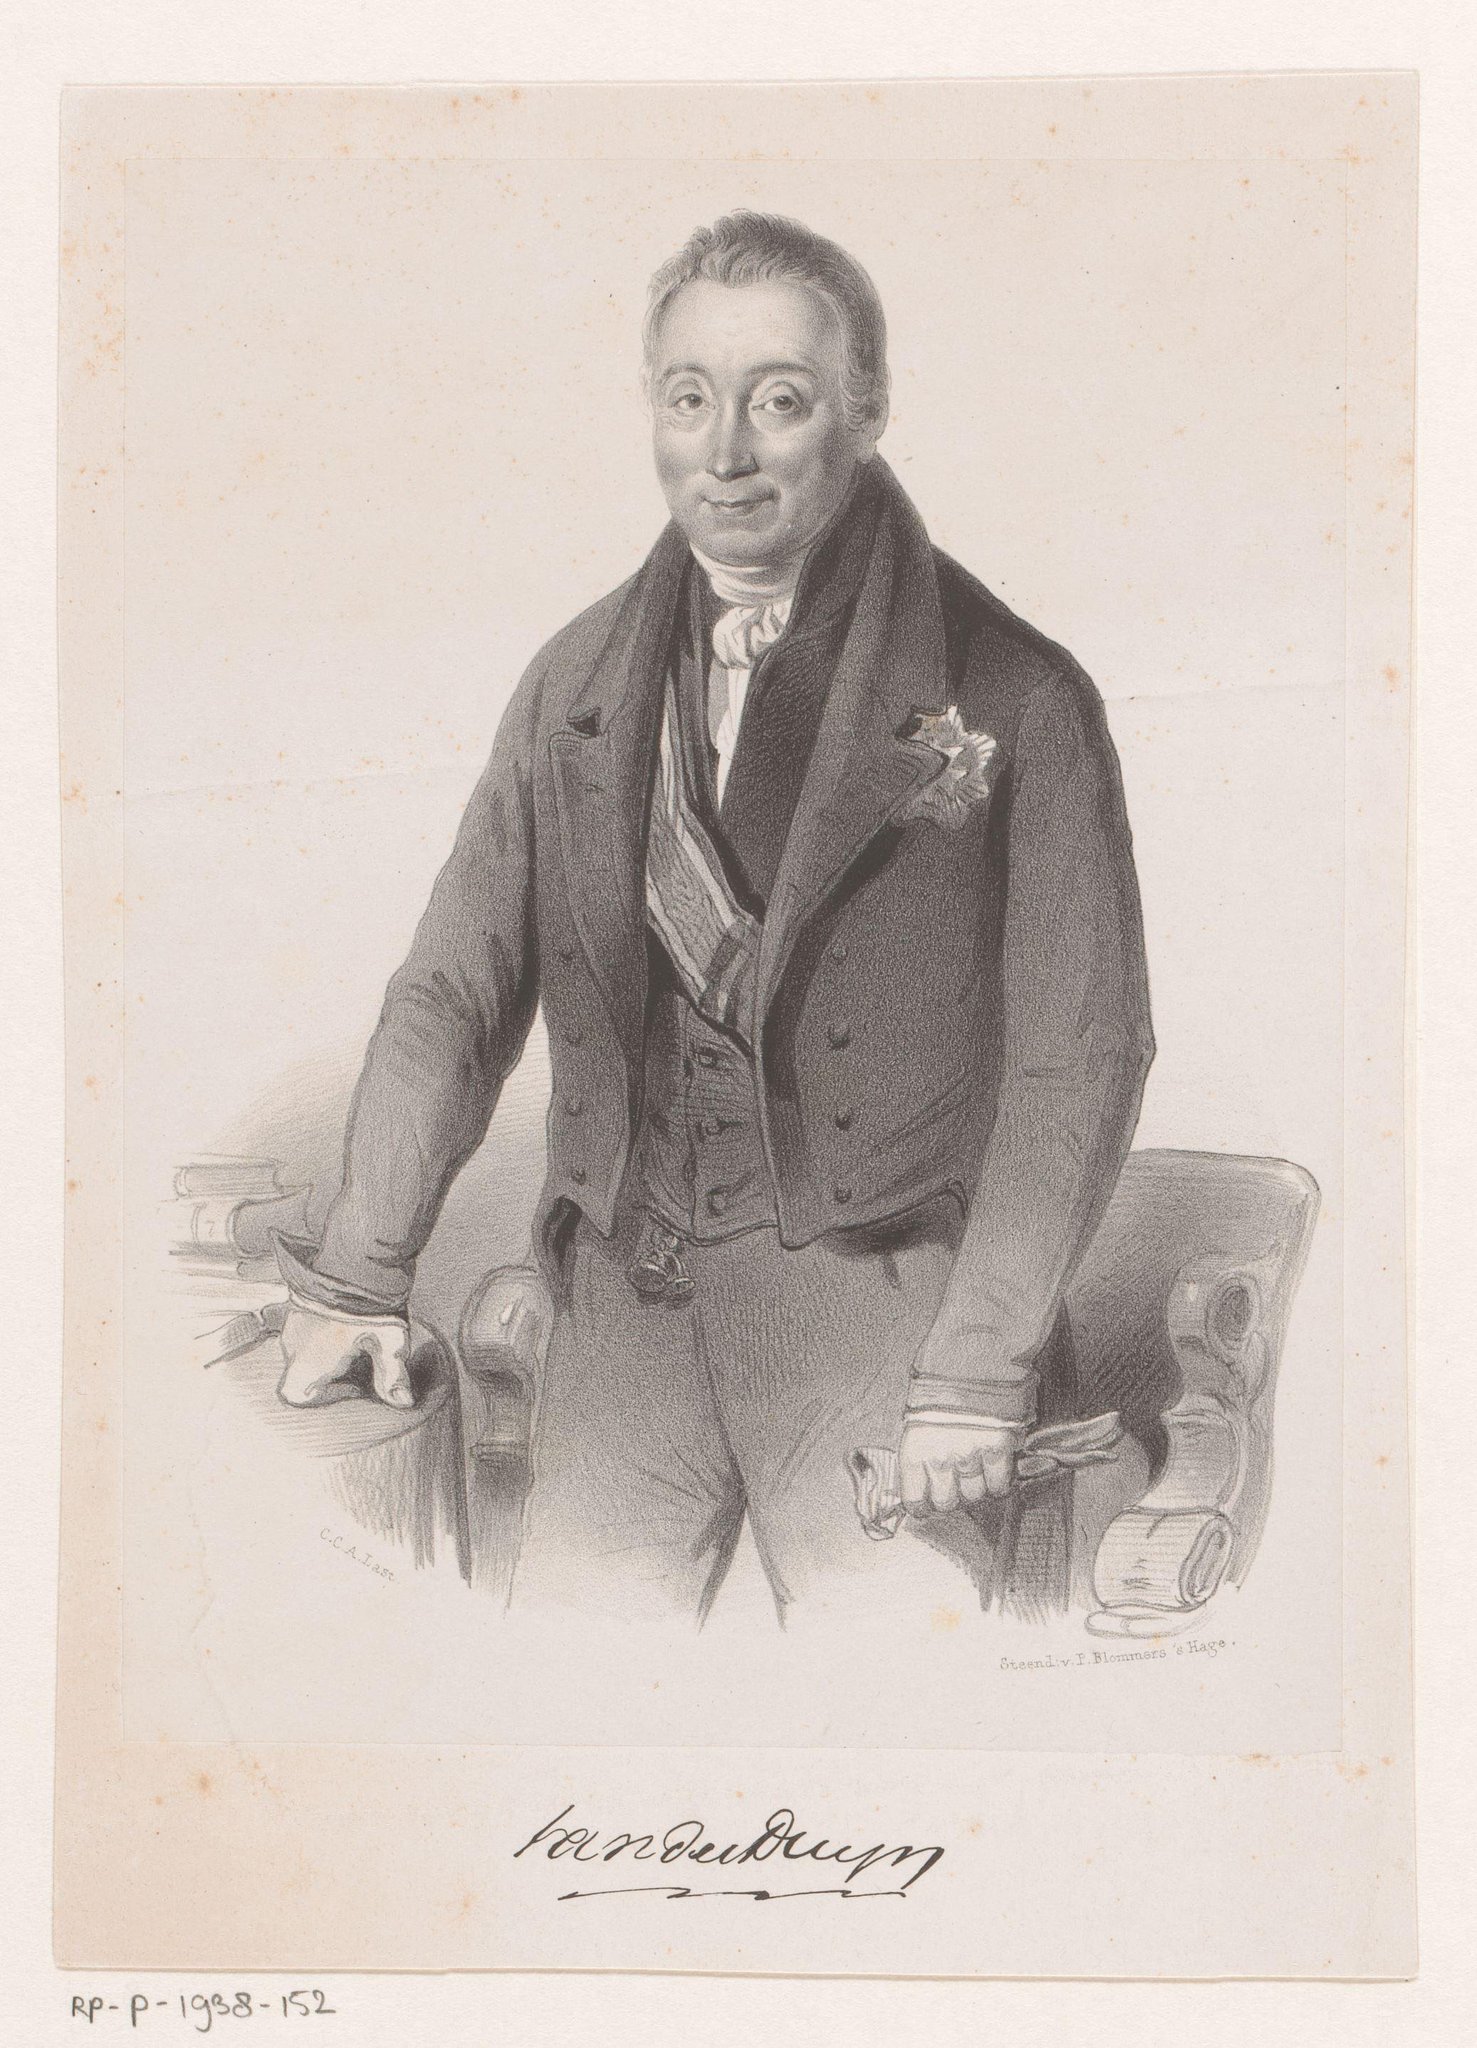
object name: print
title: Portret van Van der Duyn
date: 1842-1887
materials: paper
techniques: lithograph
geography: the hague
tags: knighthood order, historical persons (+ three-quarter length portrait)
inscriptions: collector's mark: Lugt 2228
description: De geportretteerde staat bij een stoel en een tafel. Hij draagt een ridderorde op zijn borst. Onder het portret zijn signatuur.